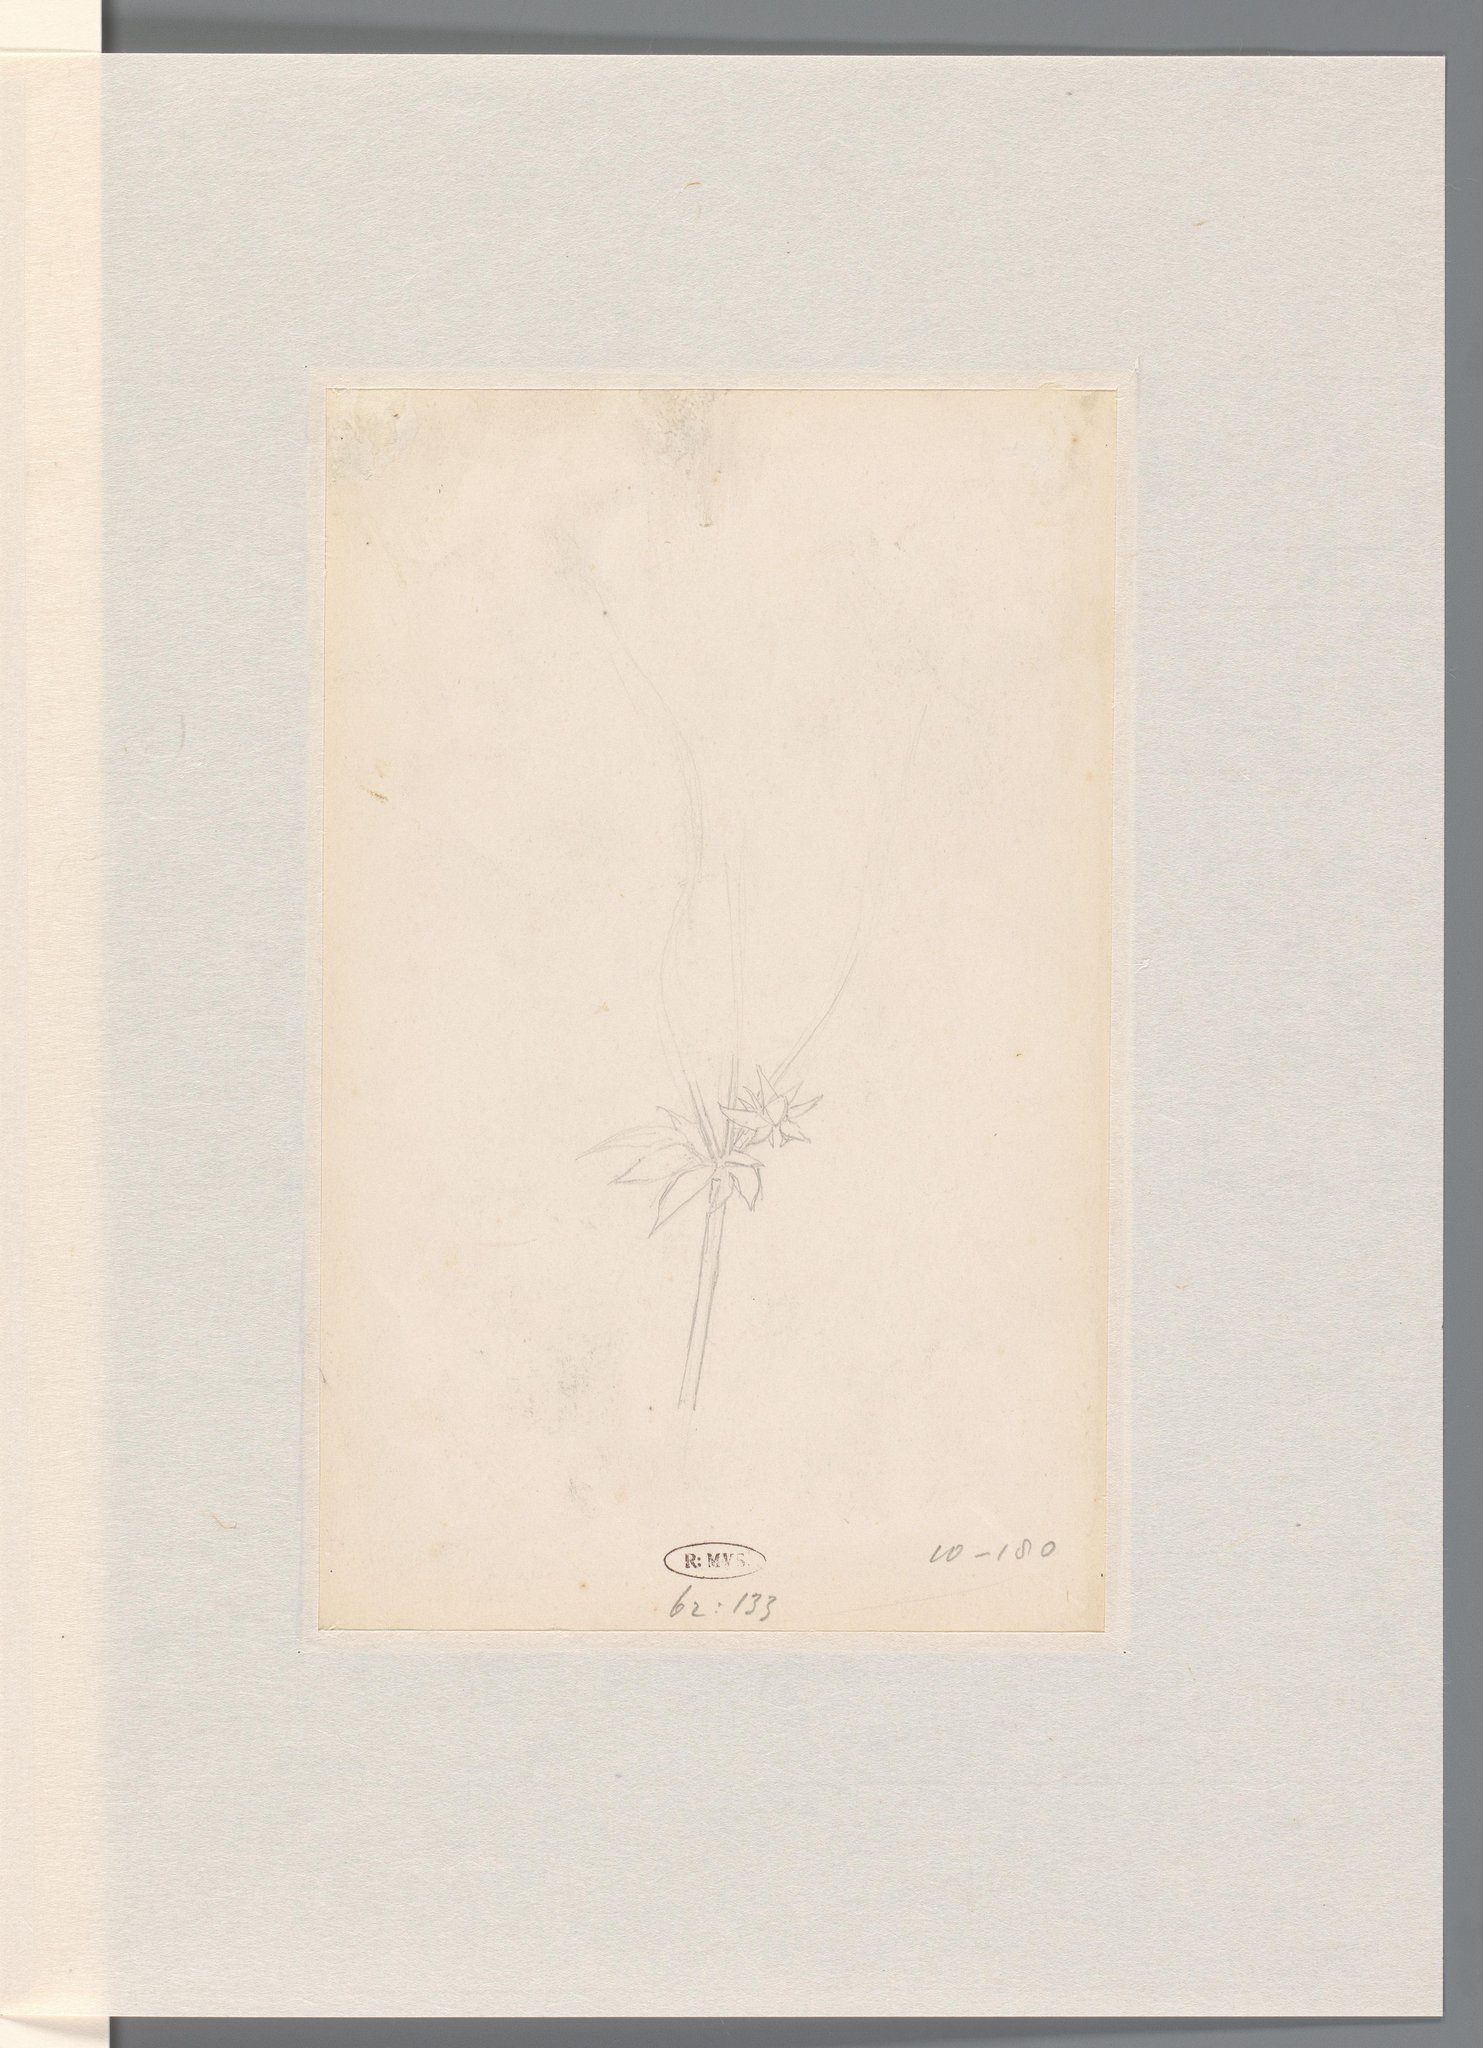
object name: drawing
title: Bloemstudie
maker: jan veth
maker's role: designer, draughtsman, painter, print maker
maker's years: 1864-1925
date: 1874-1925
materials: paper, pencil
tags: flowers